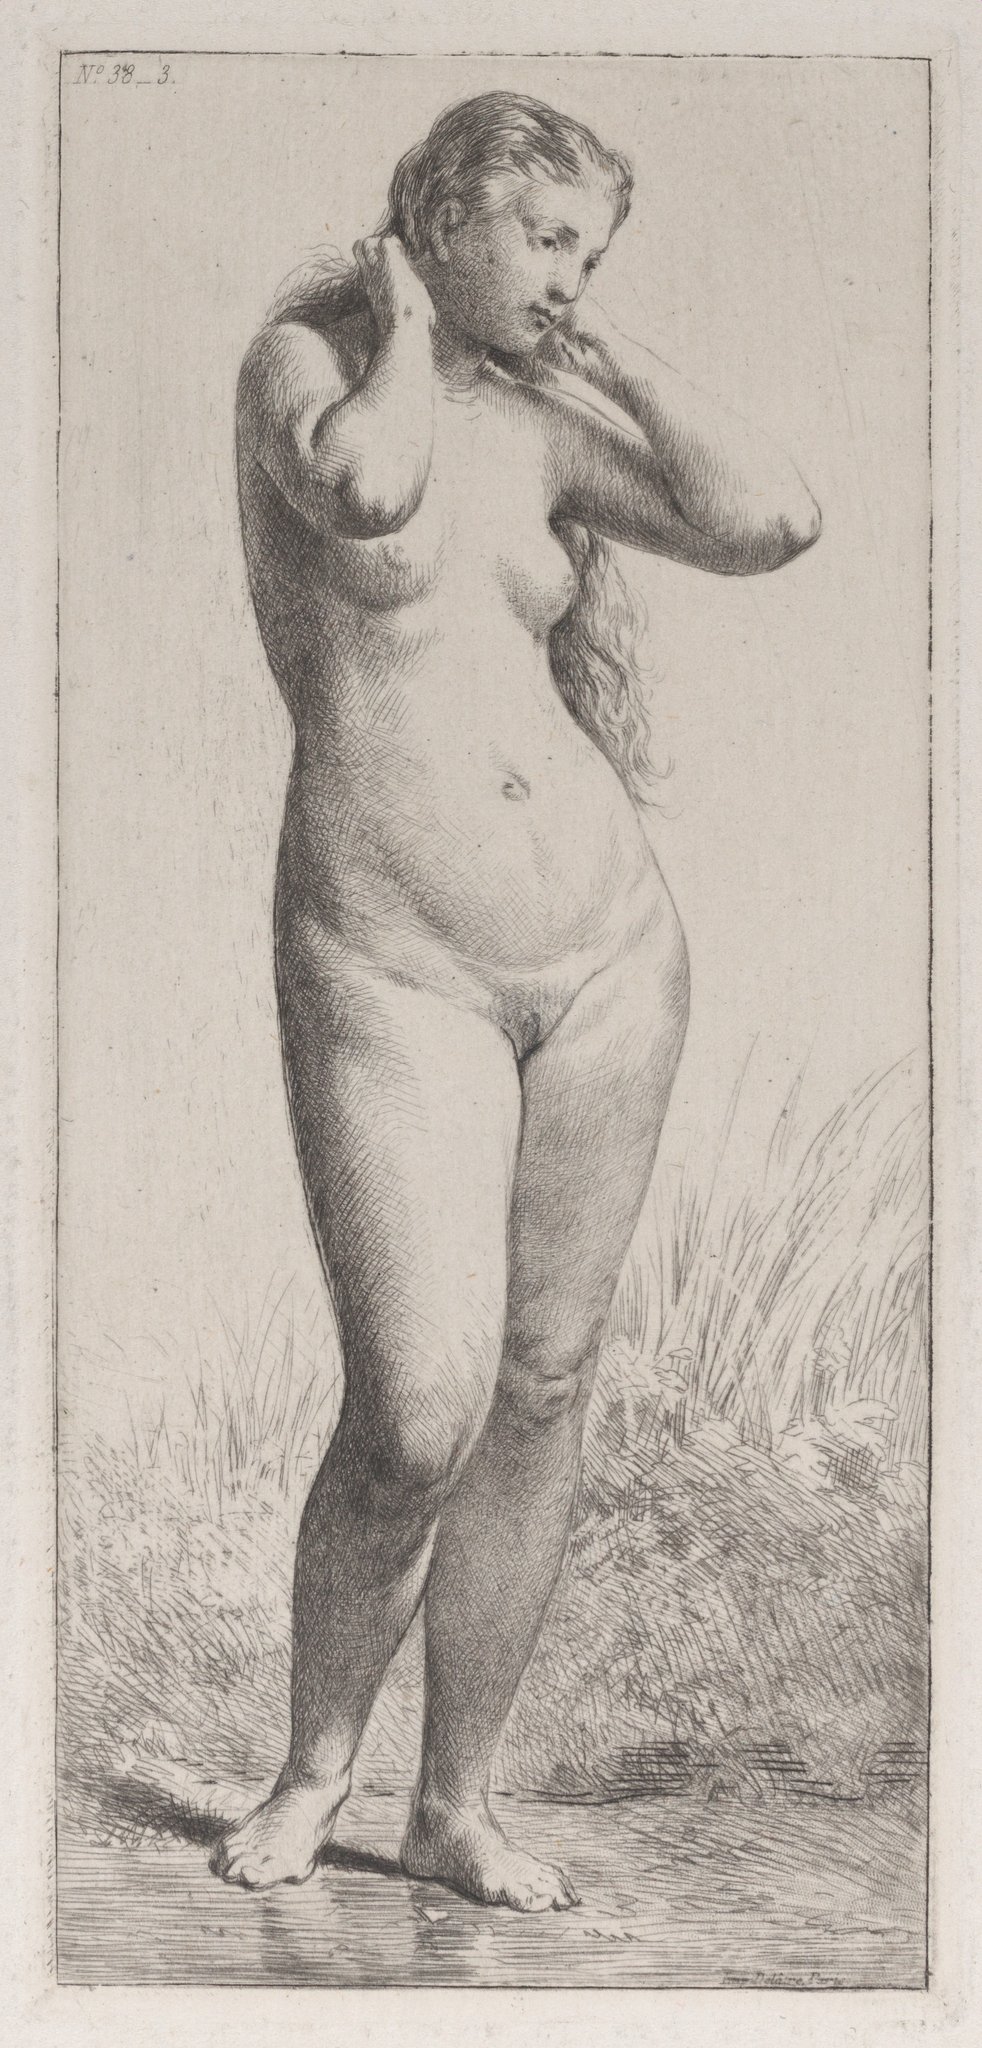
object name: print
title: The Young Bather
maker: charles émile jacque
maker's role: artist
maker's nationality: french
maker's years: 1813-1894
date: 1843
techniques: etching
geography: paris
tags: female nudes